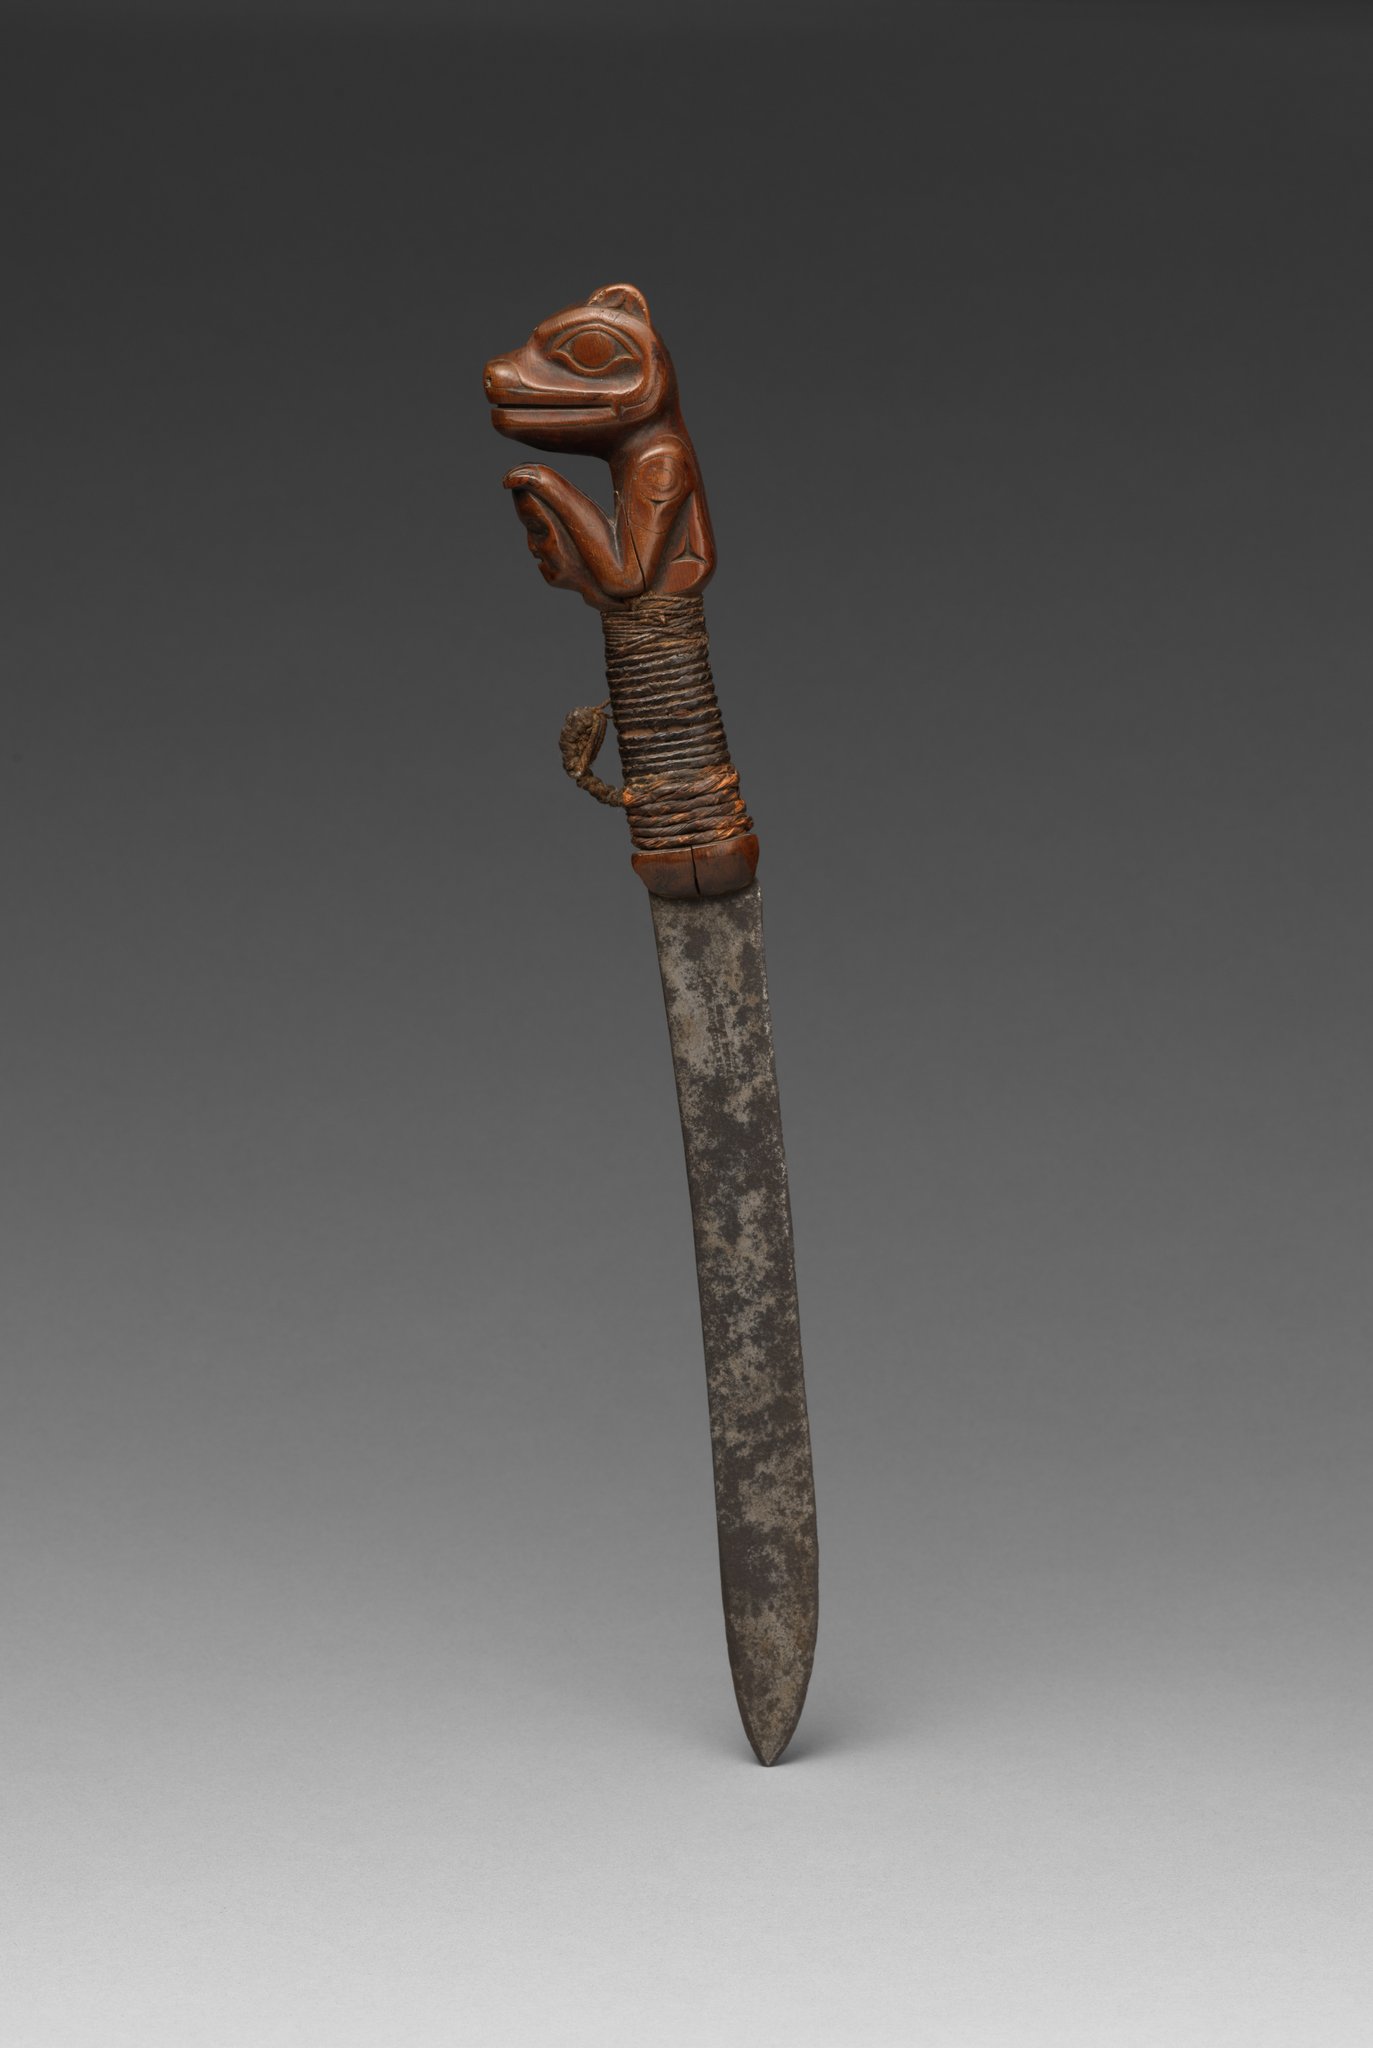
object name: dagger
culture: tlingit or native american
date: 1780-1840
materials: fiber, steel, wood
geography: united states